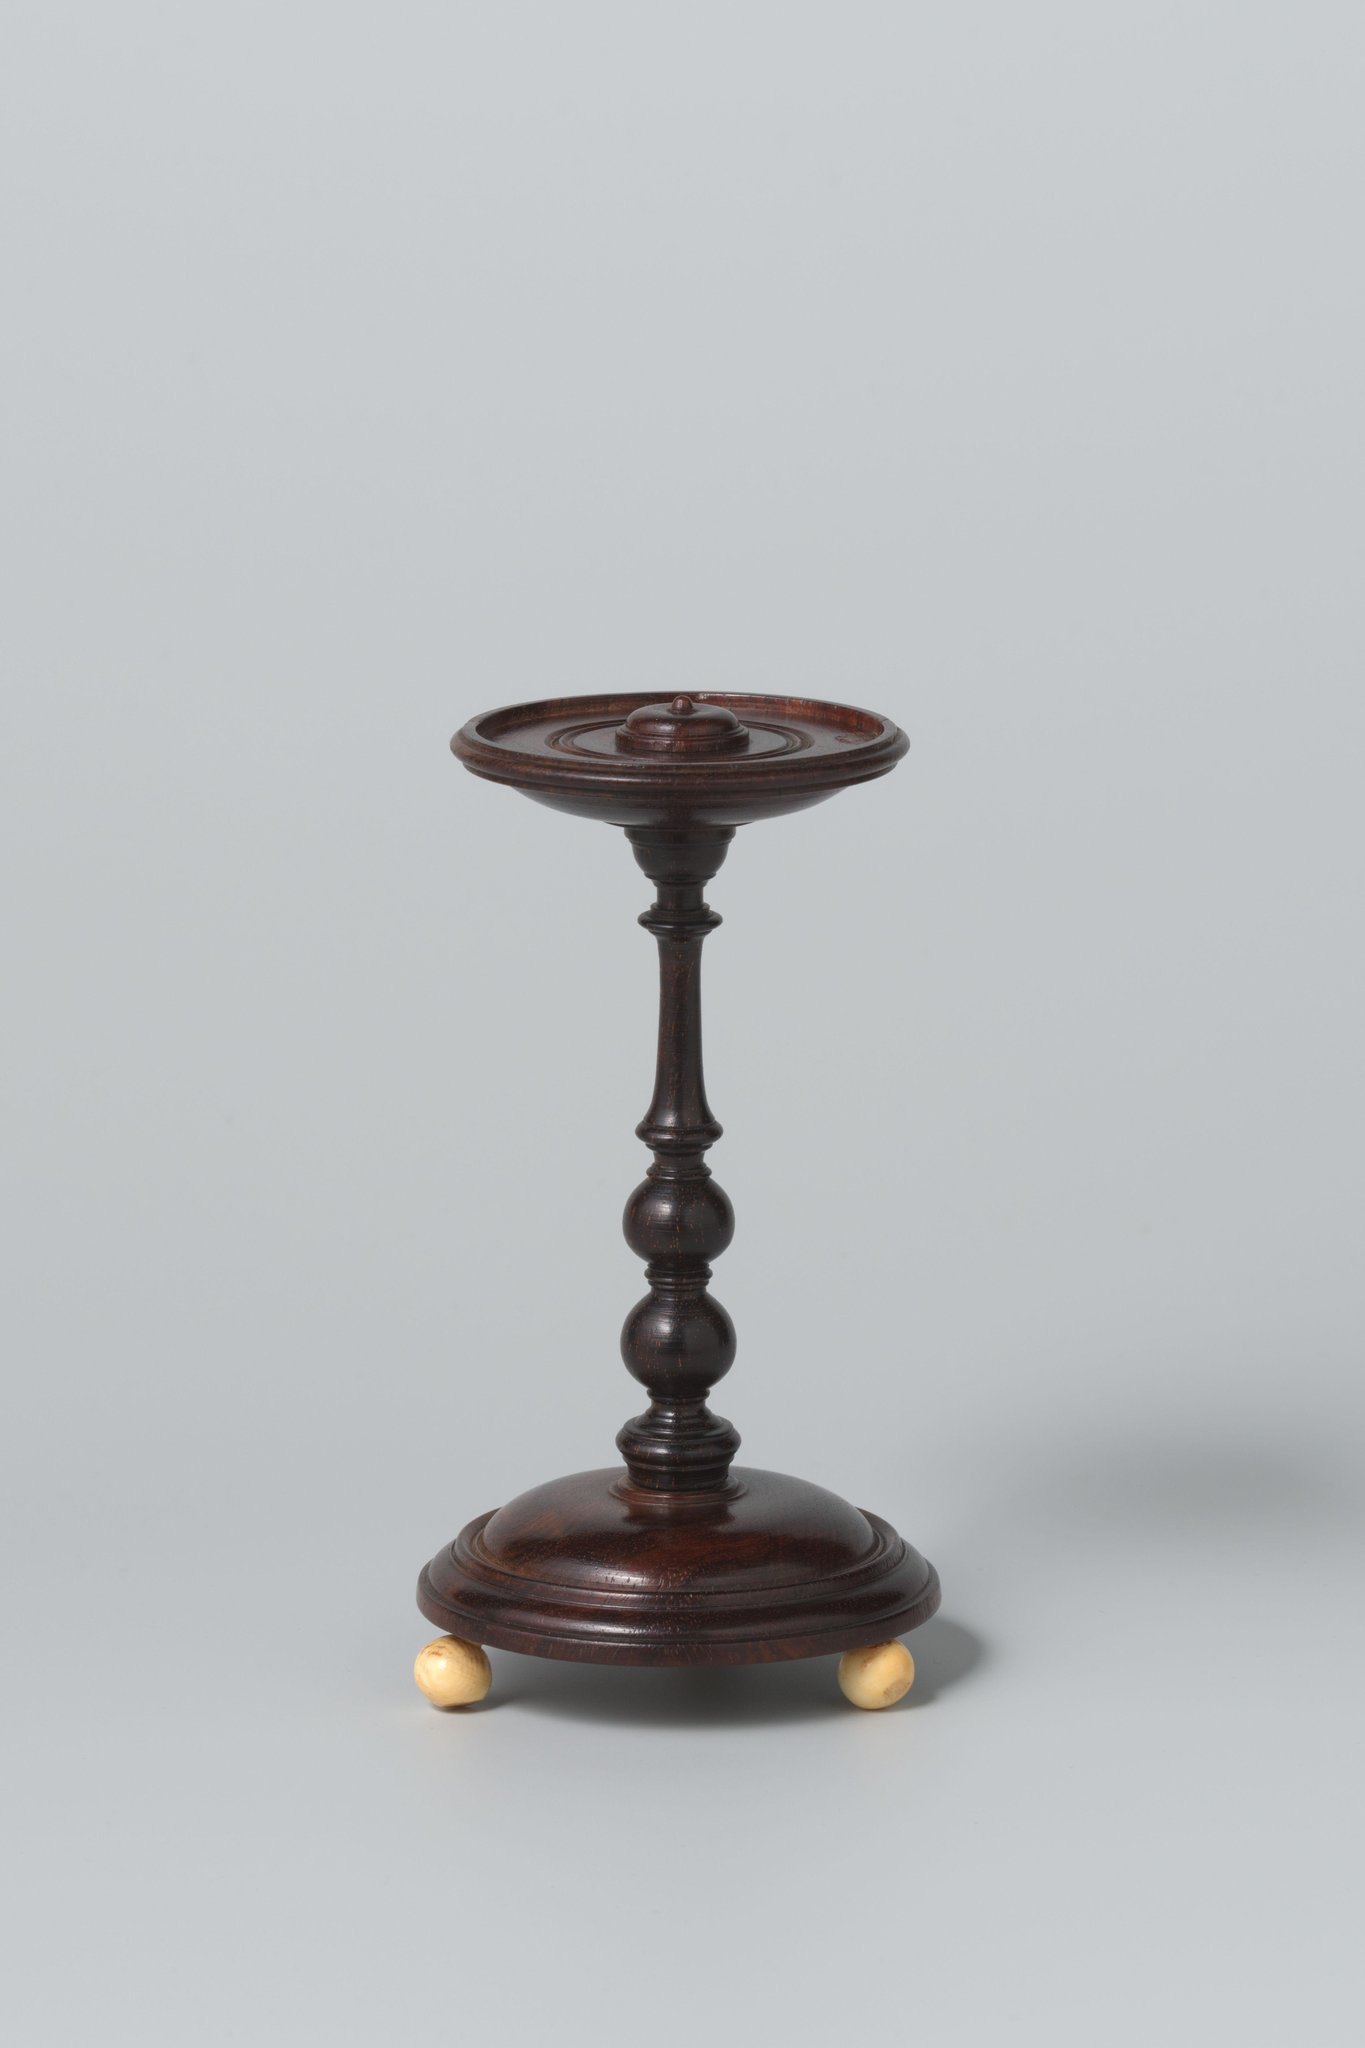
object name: miniature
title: Gueridon van palissanderhout op poten van ivoor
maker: Anonymous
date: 1676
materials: ivory, wood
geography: amsterdam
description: Gueridon, vervaardigd van palissanderhout op drie poten van ivoor. De gueridon is geheel opgebouwd uit gedraaide onderdelen. Een rond blad met opstaande geprofileerde rand met verdikking in het midden, een geprofileerde stam en idem schijfvormige grondplaat op bolpootjes.